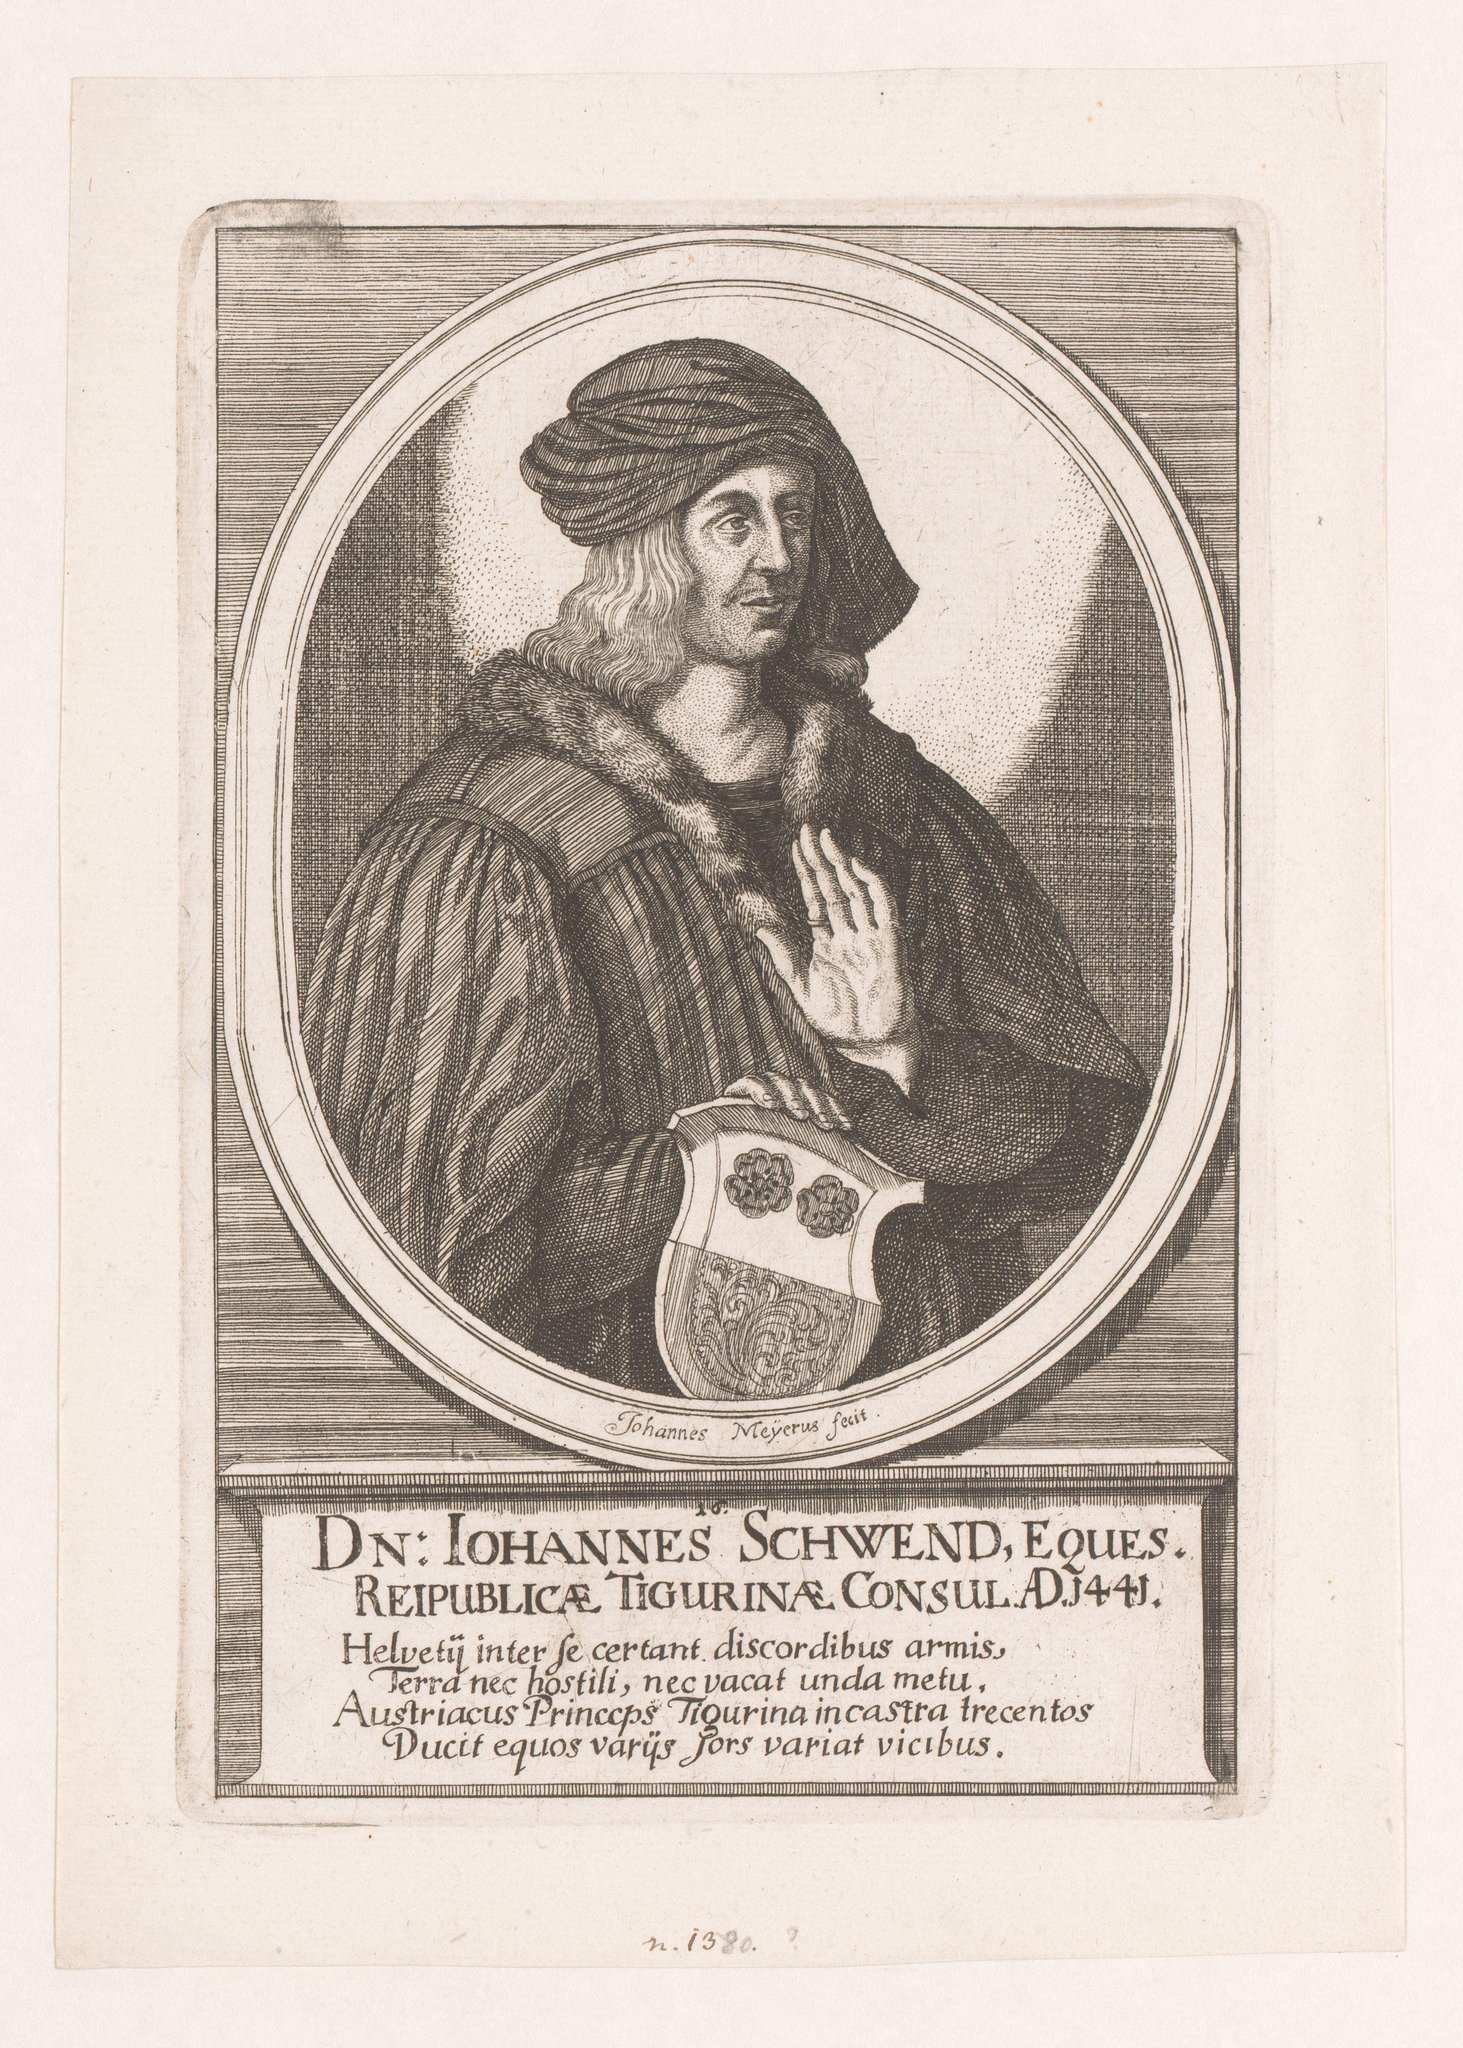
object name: print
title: Portret van Johannes Schwend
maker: johannes meyer (ii)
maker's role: print maker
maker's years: 1655-1712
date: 1665-1712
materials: paper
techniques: engraving, etching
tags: mayor, mayor, burgomaster, historical persons, armorial bearing, heraldry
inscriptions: collector's mark: Lugt 2228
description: Onderaan de ovale omlijsting genummerd: 16.